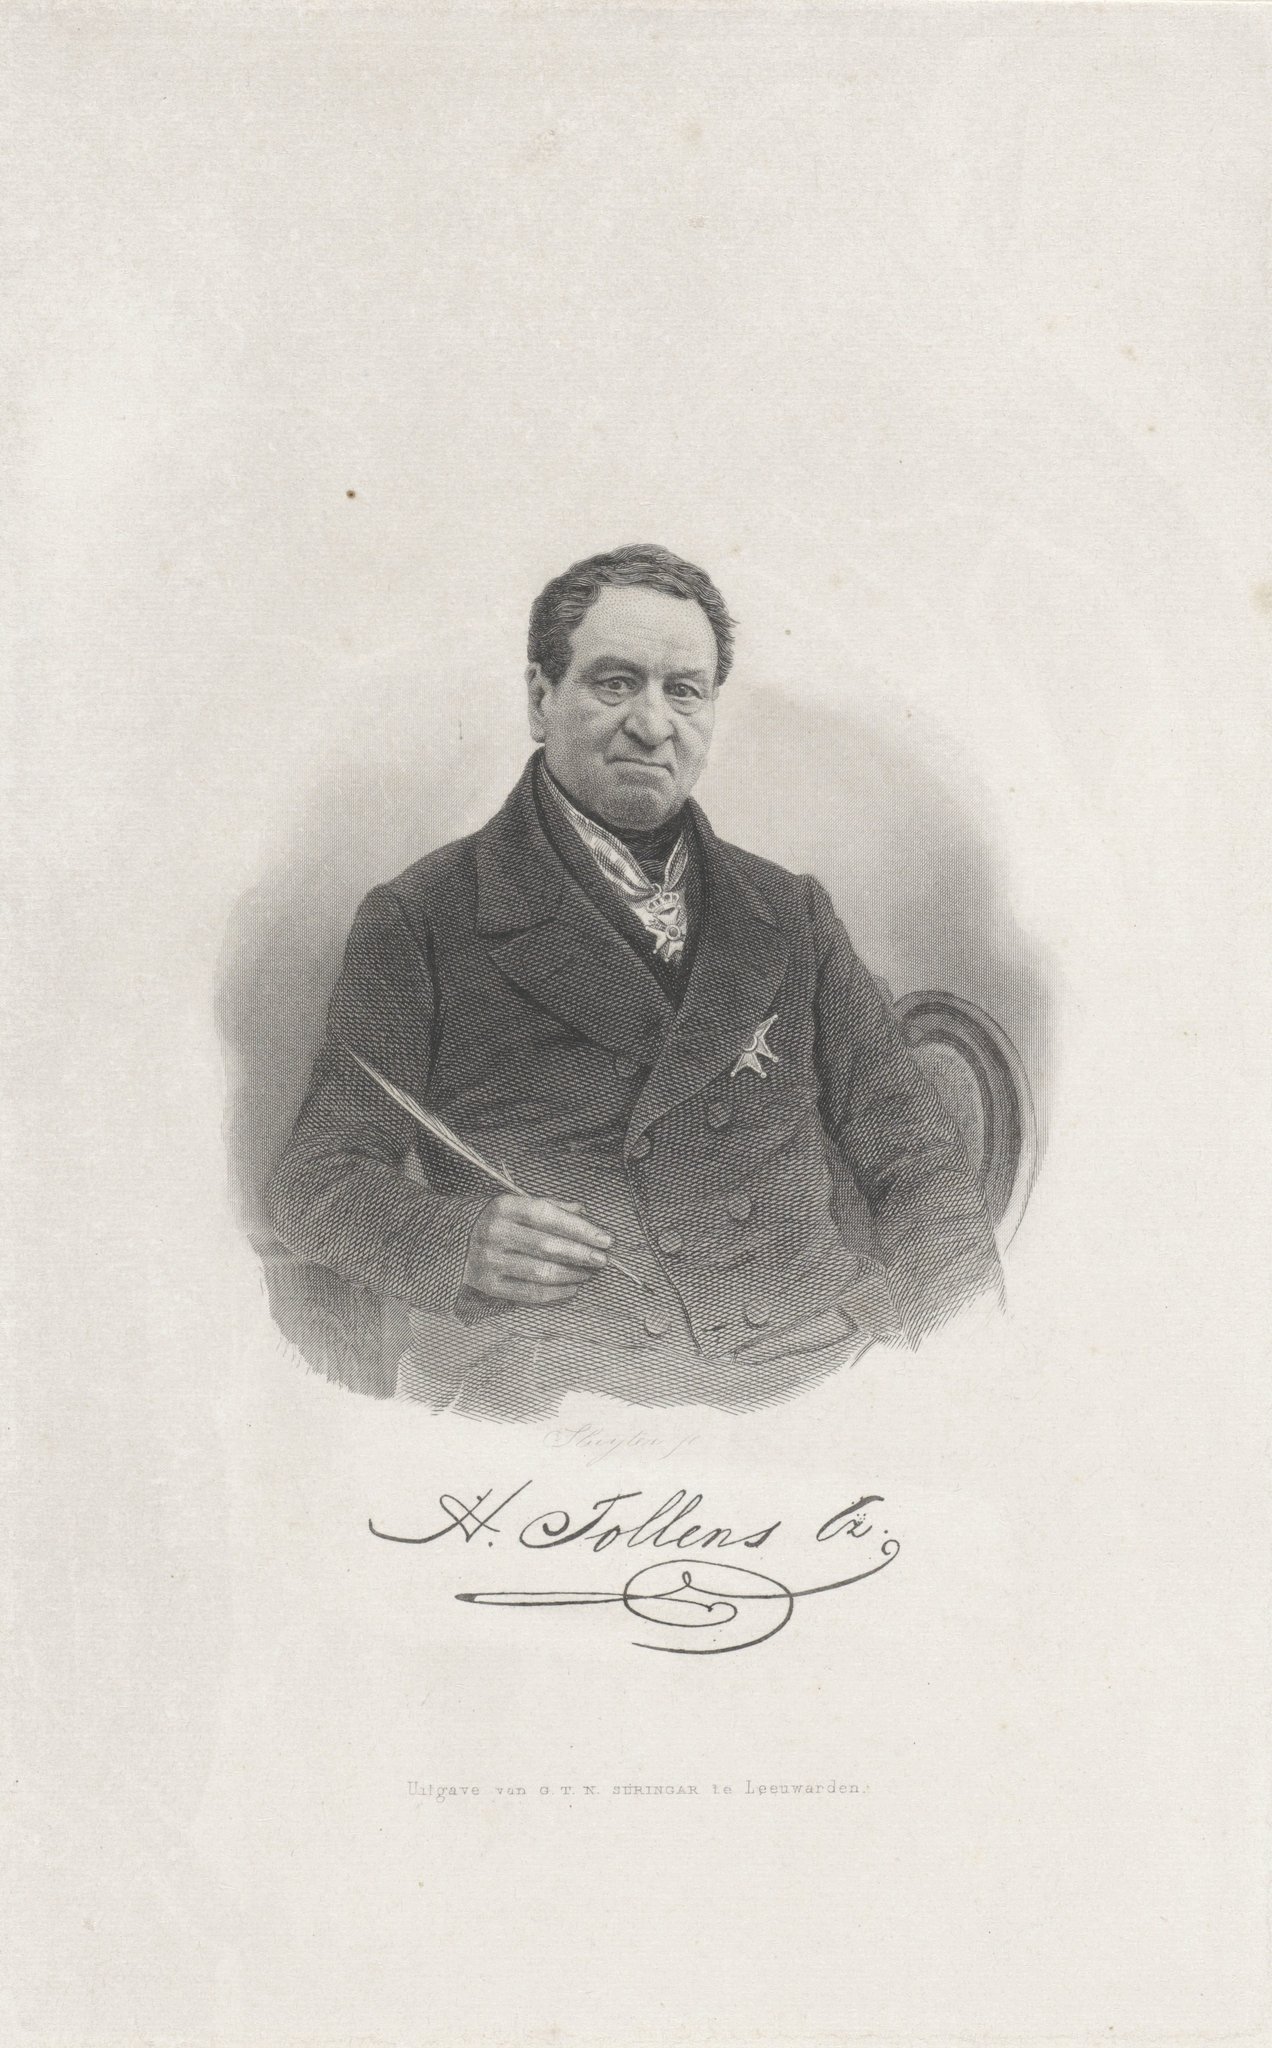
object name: print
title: Portret van Hendrik Tollens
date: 1826-1875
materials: paper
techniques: etching, engraving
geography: leeuwarden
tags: rotterdam, hendrik tollens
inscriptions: collector's mark: Lugt 2228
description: Portret van de schrijver Hendrik Tollens. Hij zit op een stoel en houdt een ganzenveren pen in zijn hand. Onder het portret zijn handtekening.